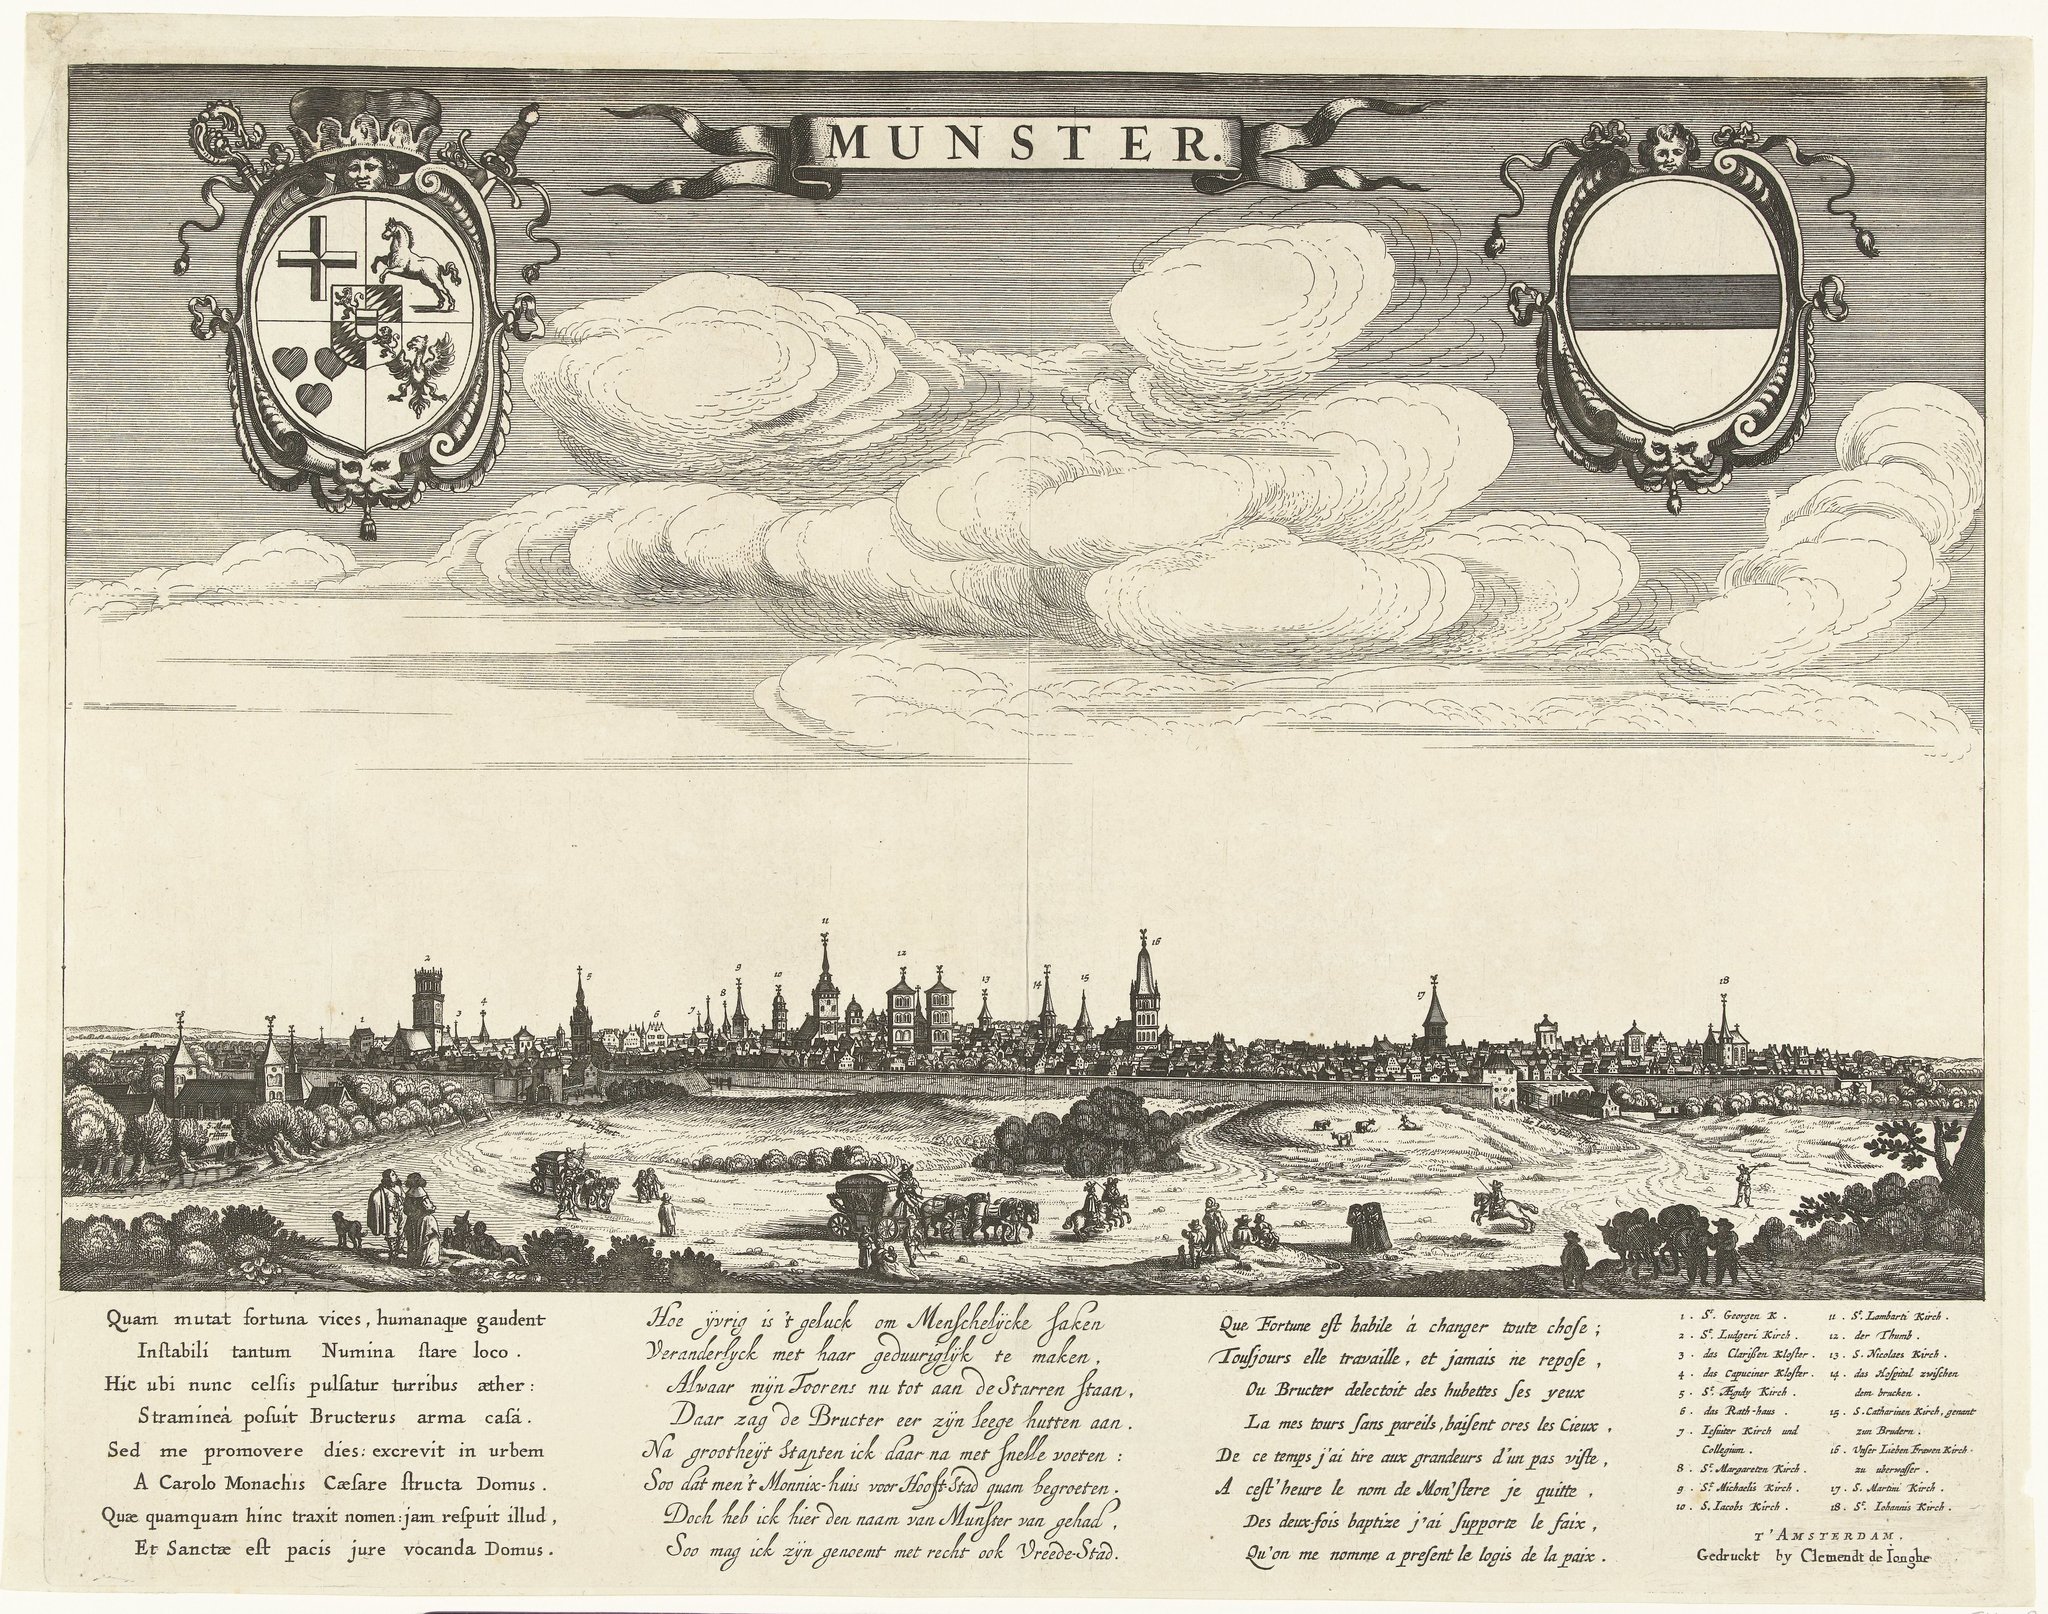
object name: print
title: Munster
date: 1648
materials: paper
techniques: etching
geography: northern netherlands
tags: münster, vrede van münster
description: Profiel van de stad Münster, op de voorgrond reizigers. In de lucht het stedelijke en het keurvorstelijke wapen. Onder de voorstellingen drie verzen van acht regels in het Latijn, Nederlands en Frans. Rechts de legenda 1-18 in het Duits.